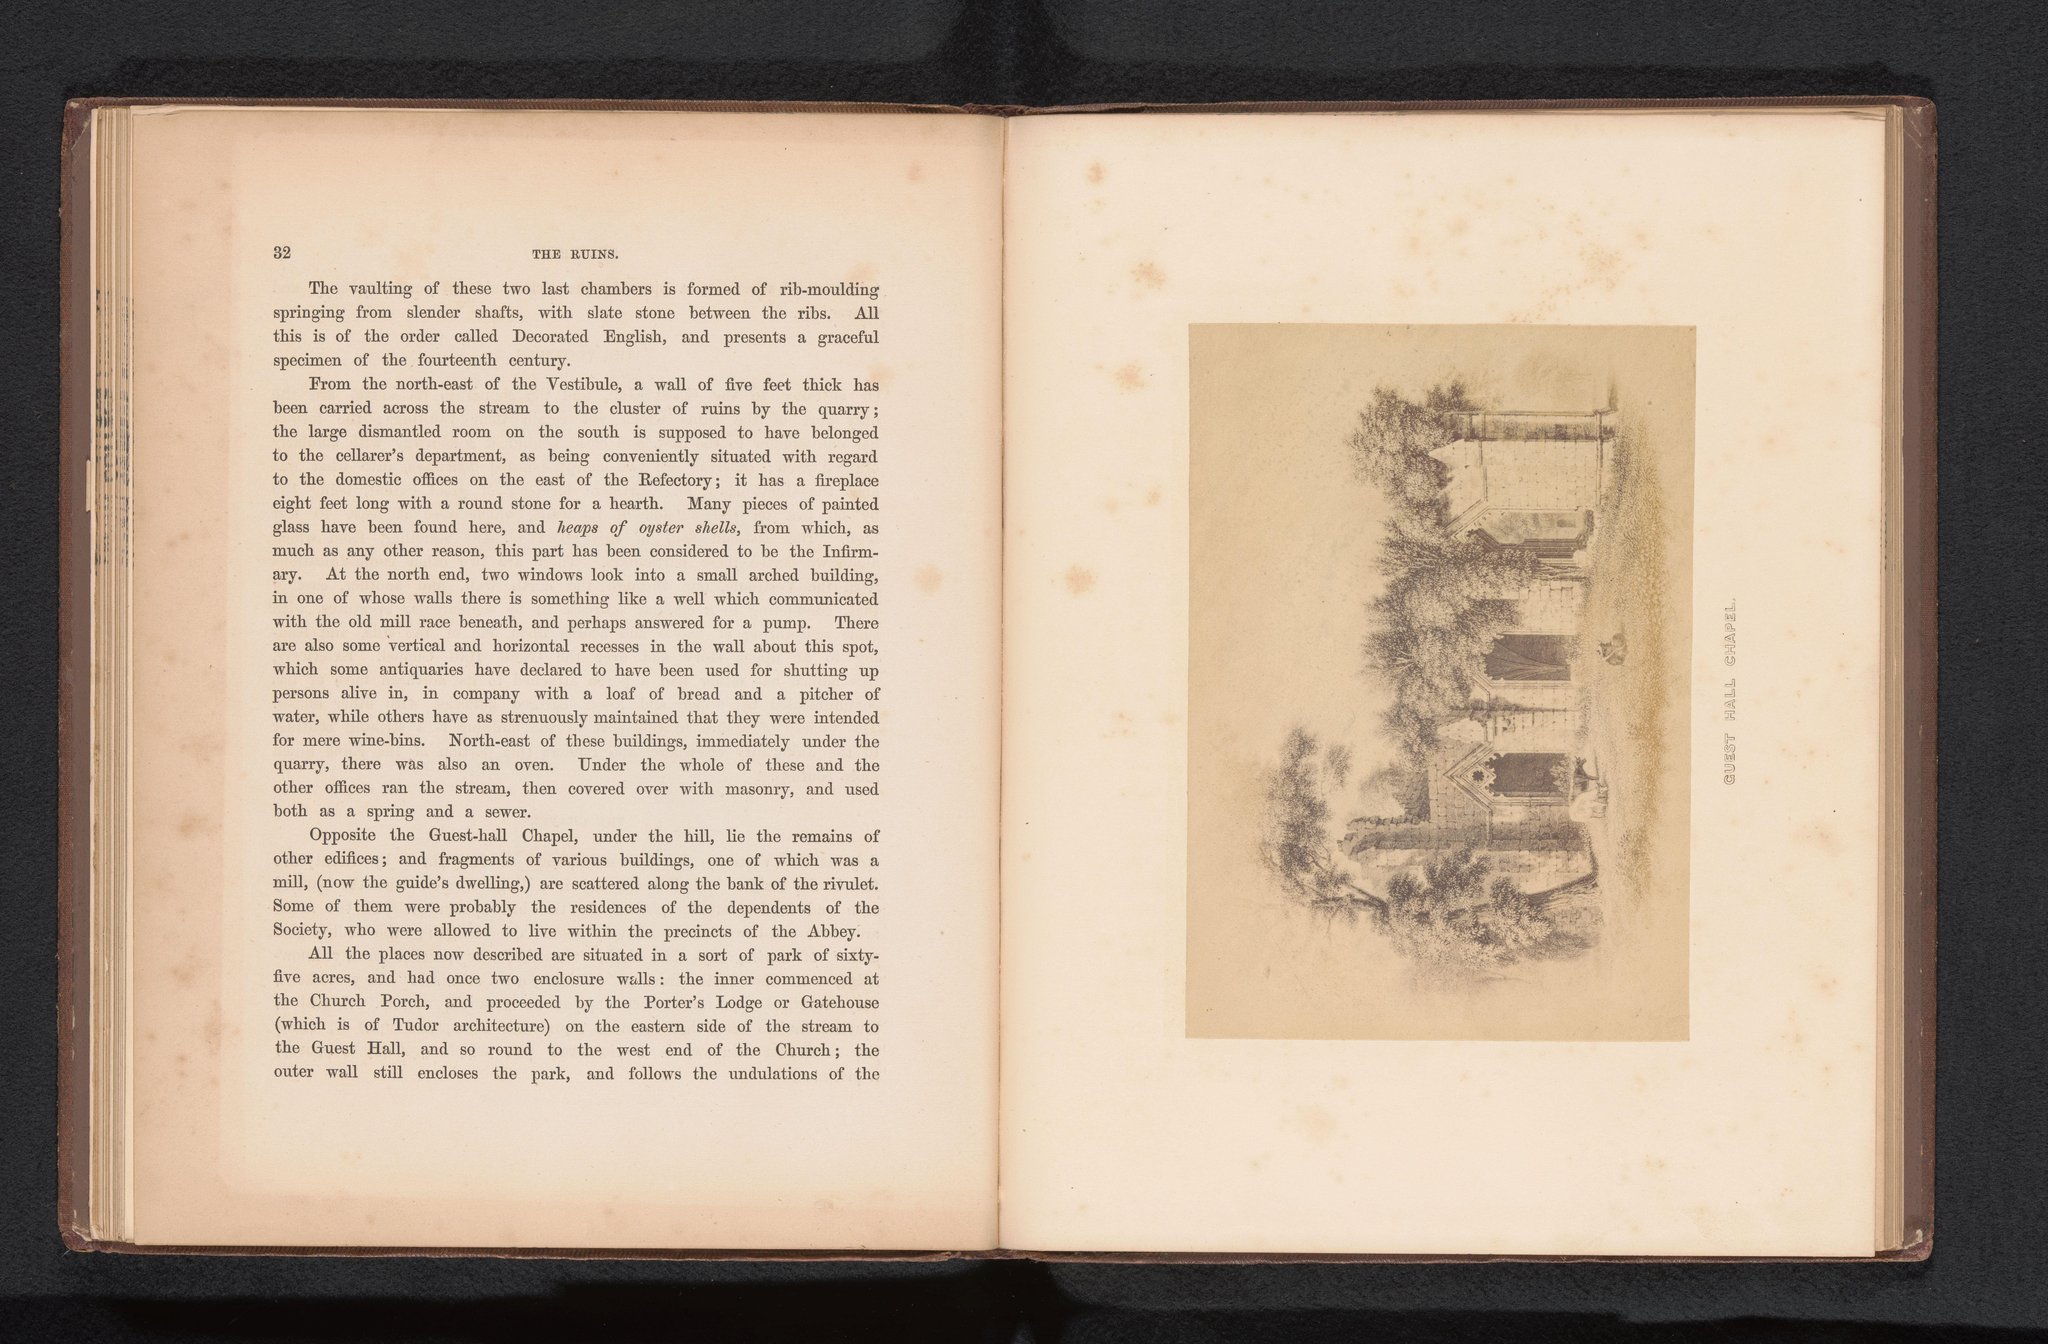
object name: photograph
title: Guest hall chapel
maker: Anonymous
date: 1859-1864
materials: photographic support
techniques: albumen print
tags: ruin of church, monastery, etc.